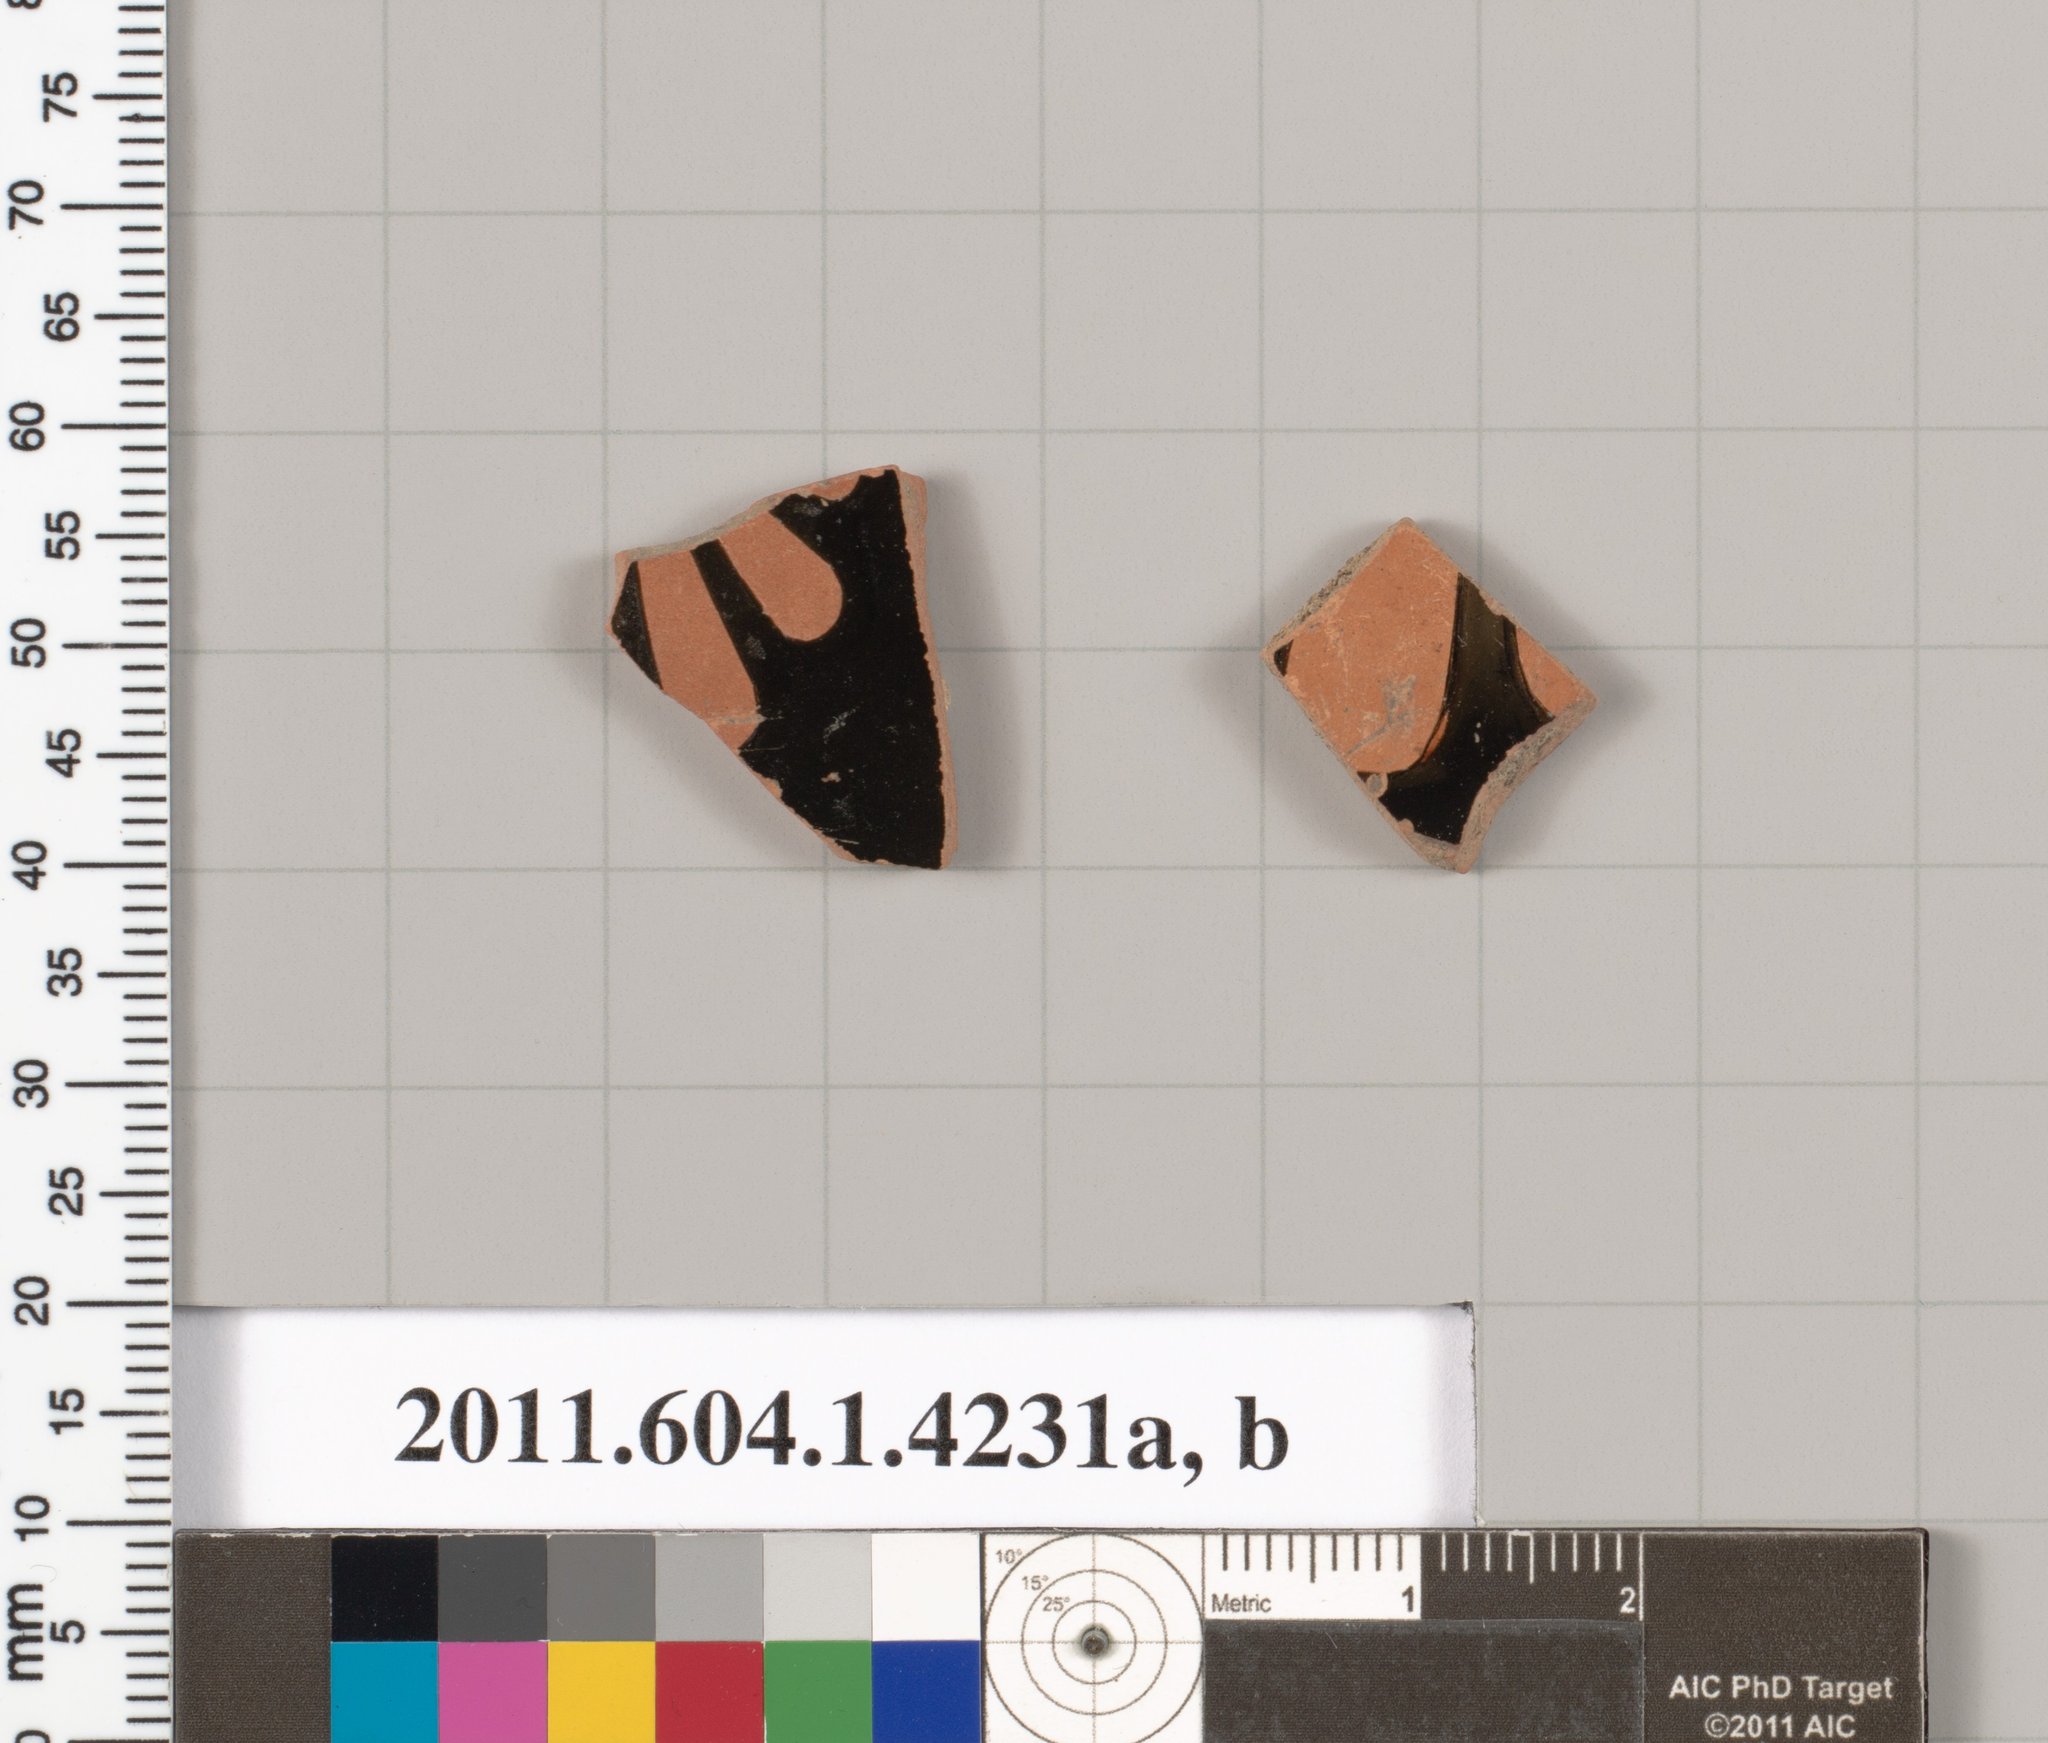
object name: kylix fragment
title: Terracotta fragments of kylikes (drinking cups)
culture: greek, attic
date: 520-500 BCE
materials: terracotta